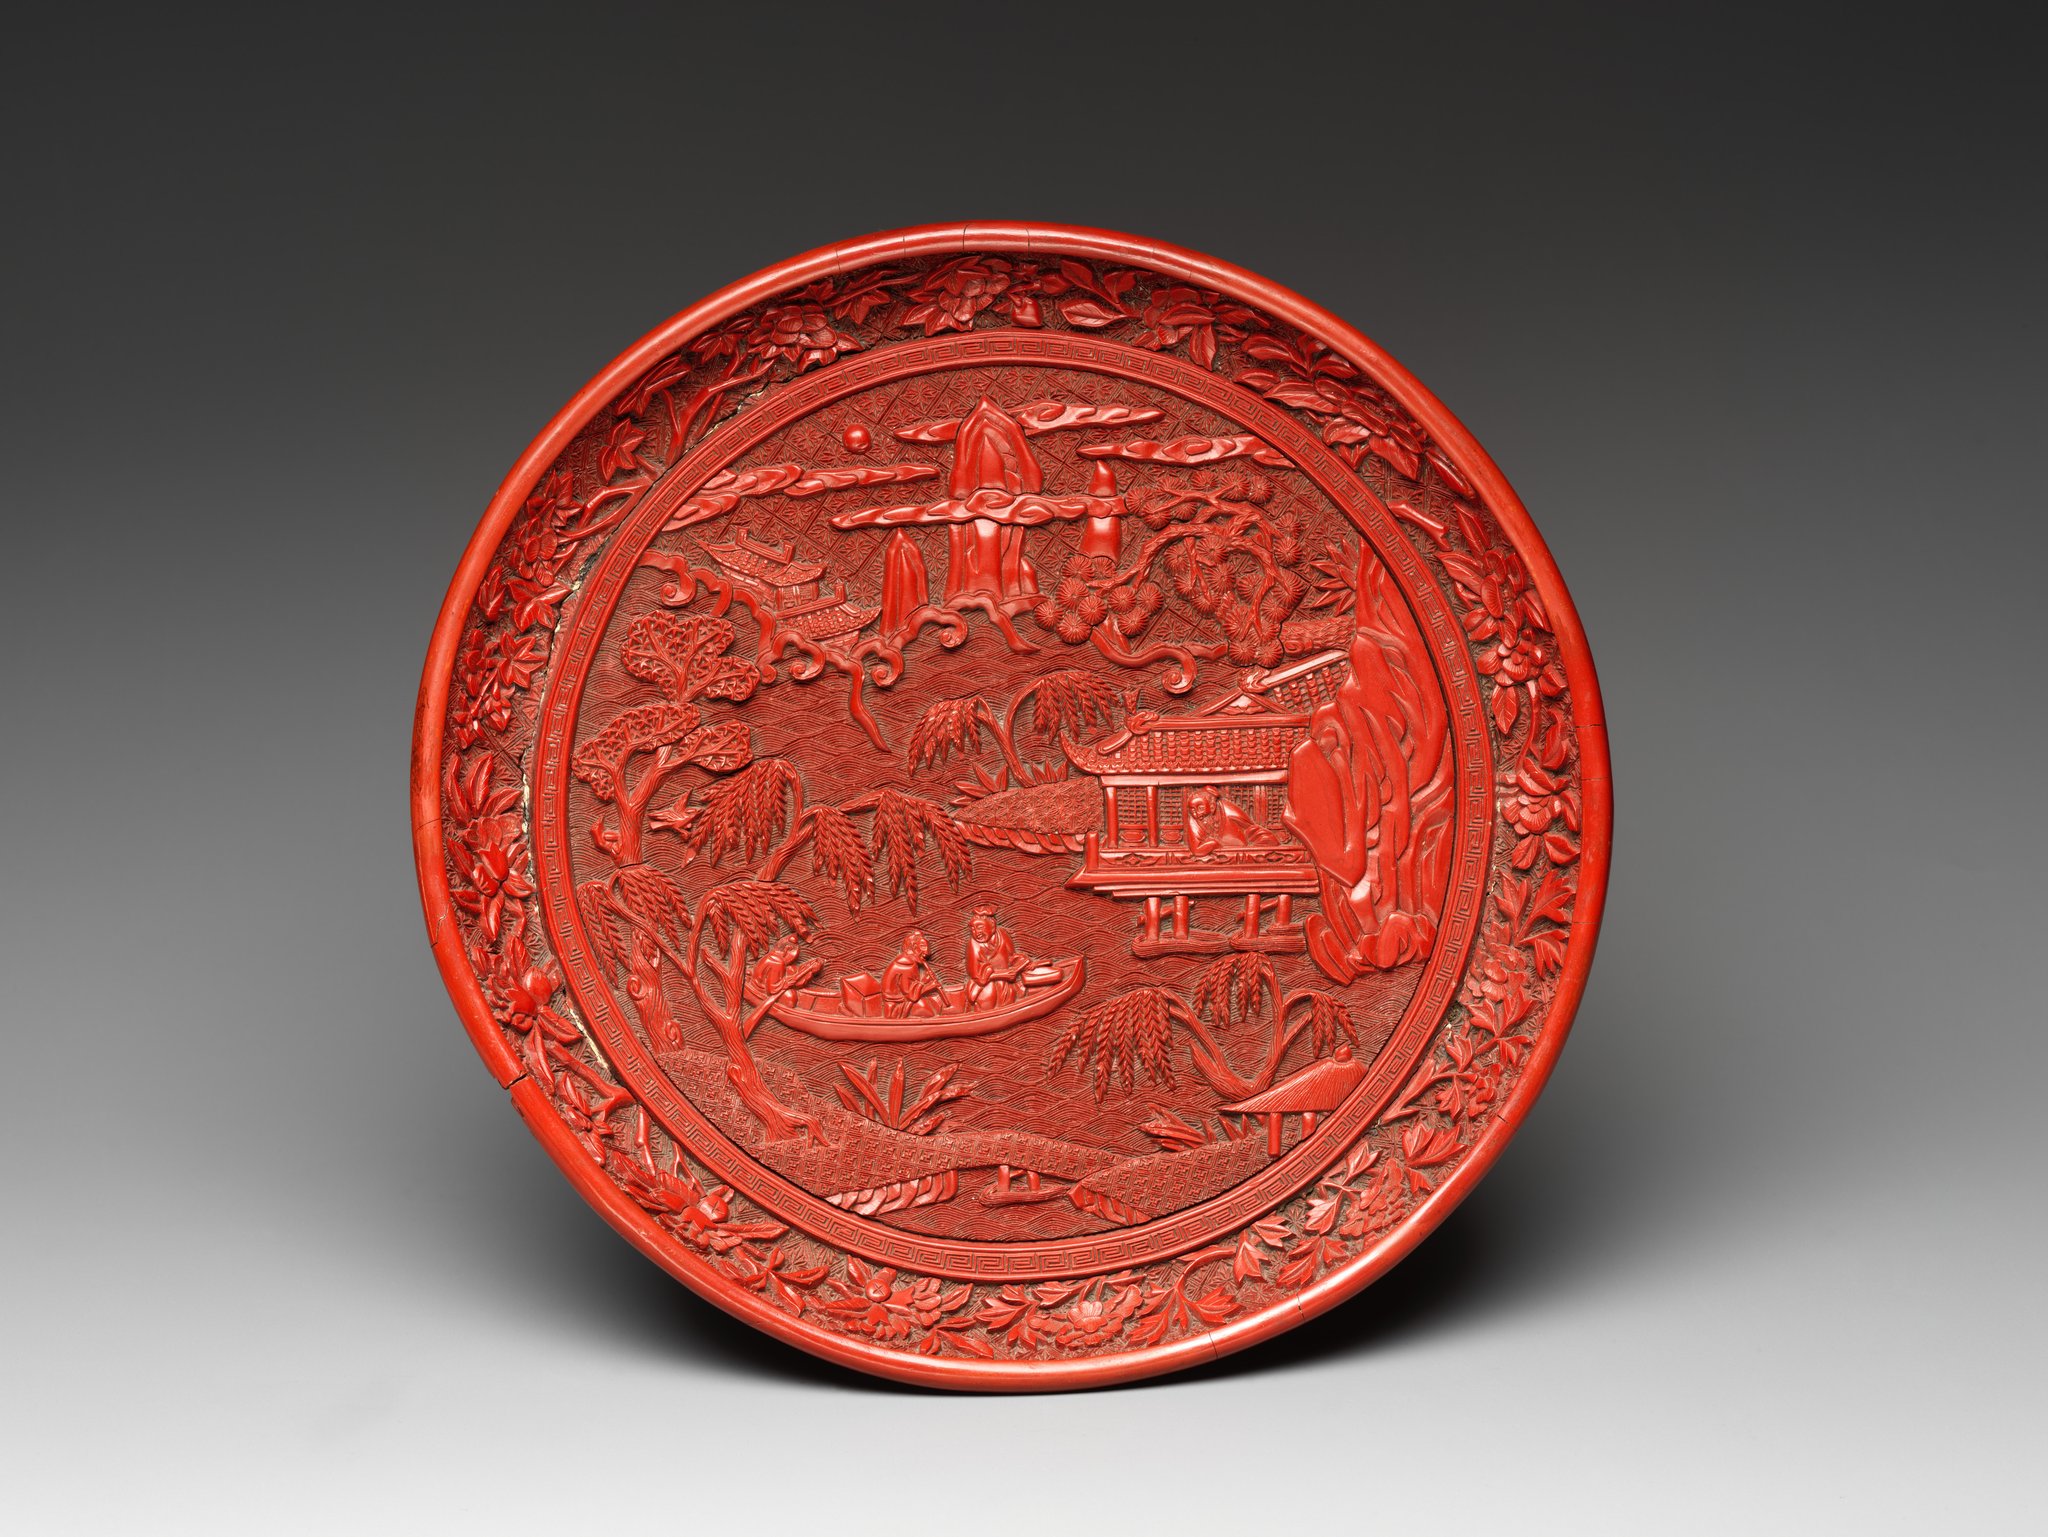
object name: dish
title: Dish with figures in a landscape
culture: chinese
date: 1567-1600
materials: lacquer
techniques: carving